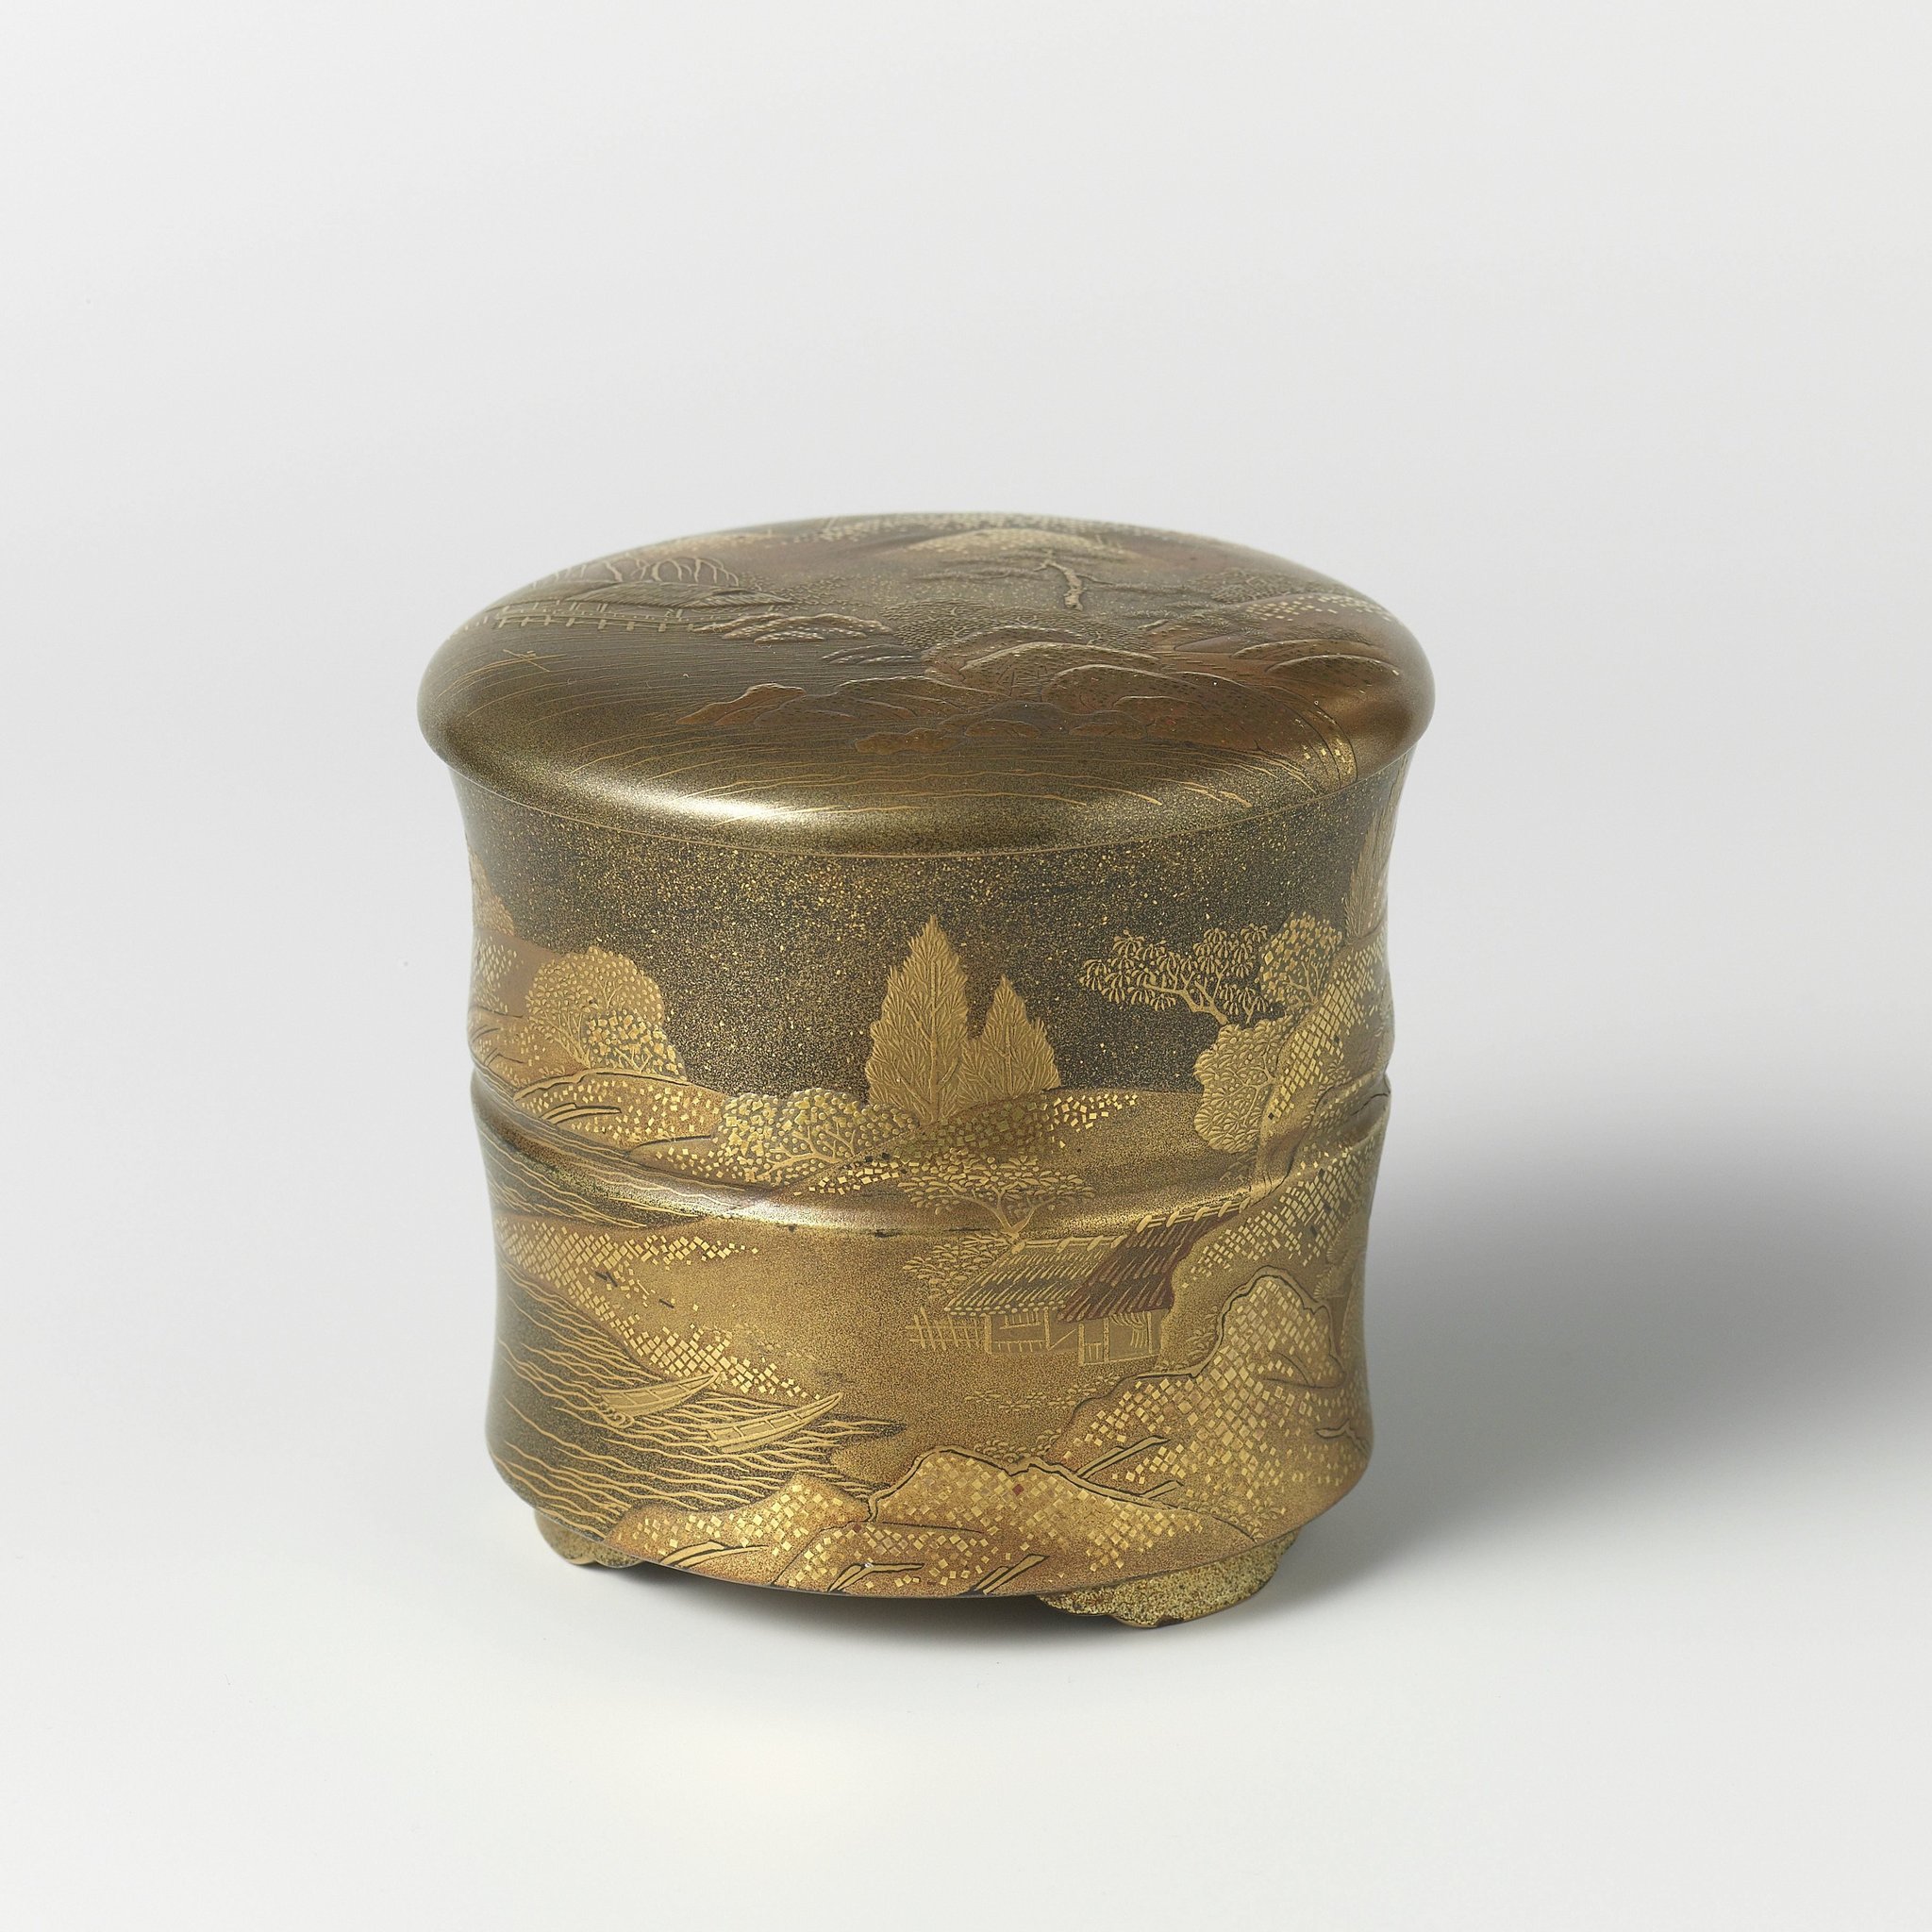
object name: box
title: Incense cinder container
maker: Anonymous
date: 1600-1899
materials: bamboo, tin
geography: japan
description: Wierookashouder van bamboe met lakwerk, versierd met een rivierlandschap. Aan de binnenzijde bekleed met tin.